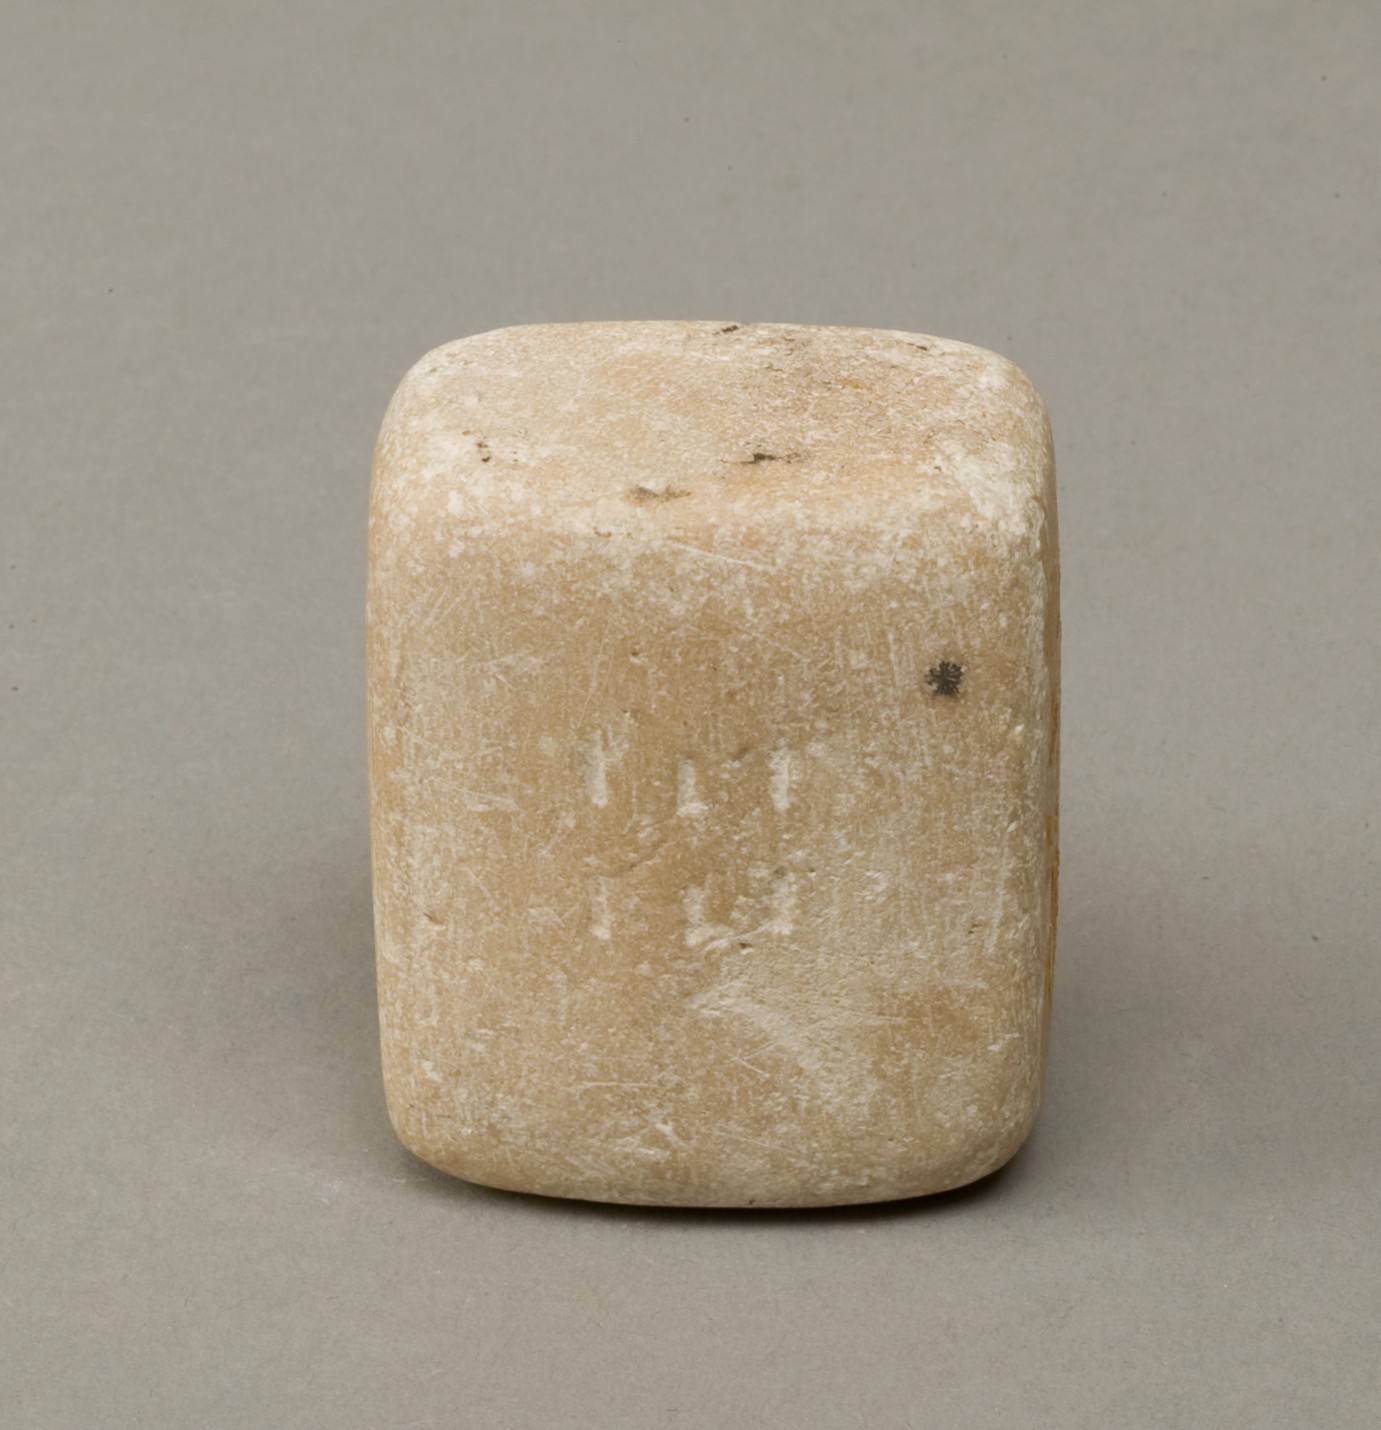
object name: weight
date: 1981-1640 BCE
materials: limestone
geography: egypt